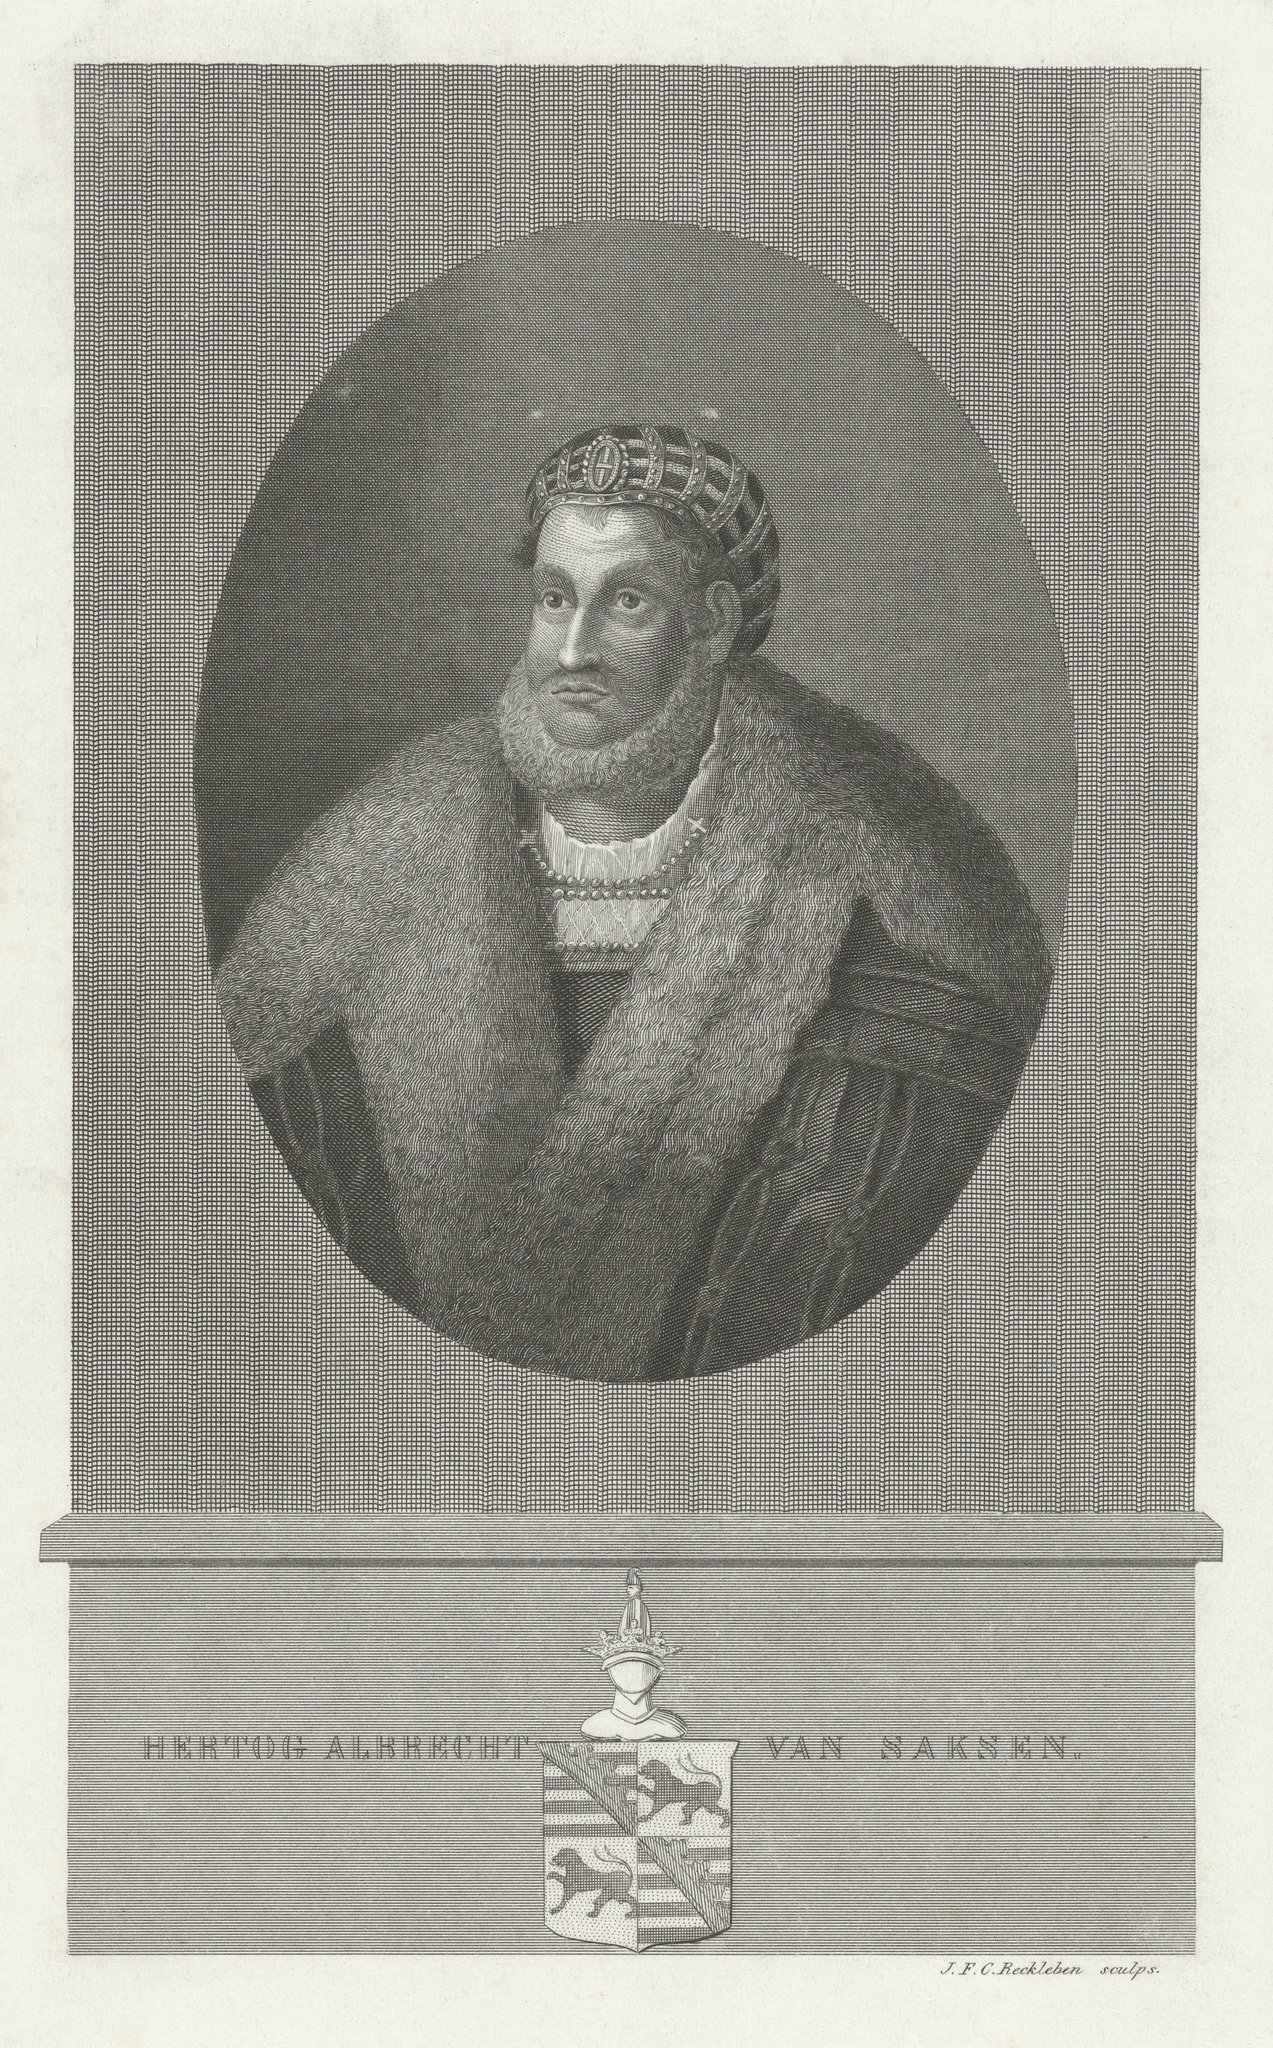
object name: print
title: Portret van Albrecht III van Saksen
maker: jan frederik christiaan reckleben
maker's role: print maker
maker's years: 1819-1879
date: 1847-1849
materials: paper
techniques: engraving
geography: amsterdam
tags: grimma, emden, hertog, albrecht de kloekmoedige (hertog van saksen)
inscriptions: collector's mark: Lugt 2228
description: Illustratie in: Arend, Johannes Pieter. Algemeene geschiedenis des vaderlands van de vroegste tijden tot op heden. 5 delen, Amsterdam: Schleijer, J.F. 1840-1884, dl. 2.3, p. 506.